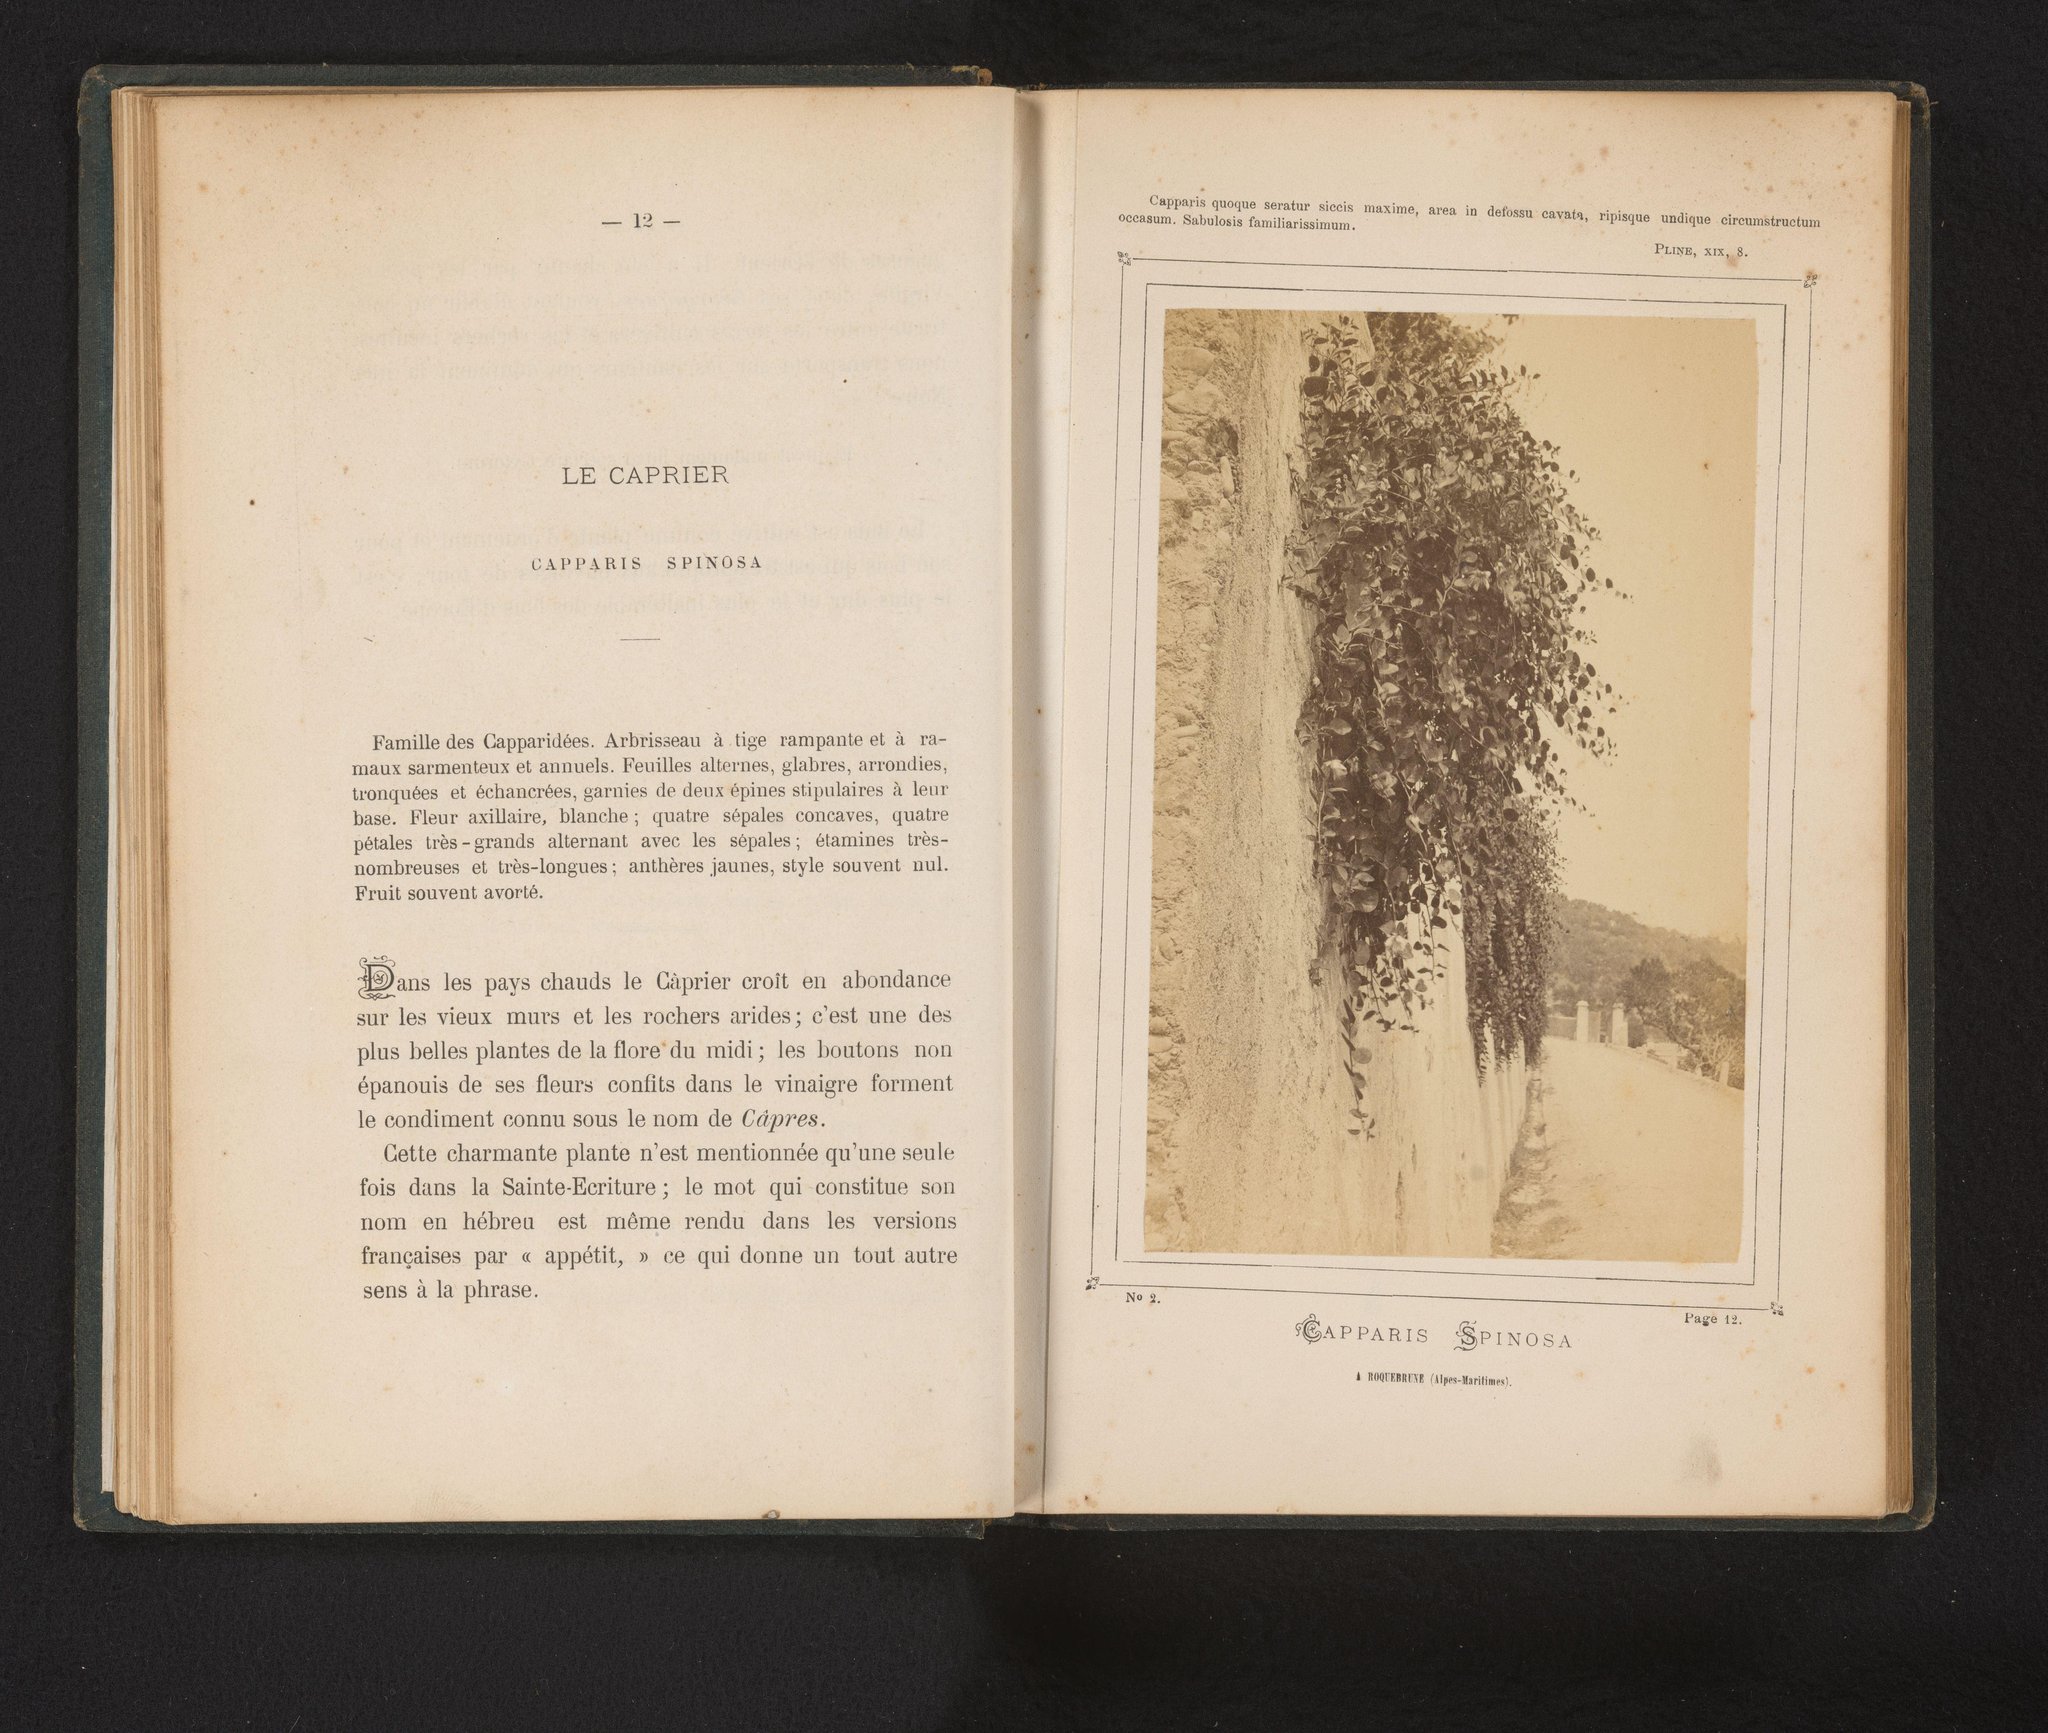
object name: page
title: Capparis Spinosa, A Rocquebrune (Alpes Maritimes)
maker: jean walburg de bray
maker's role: fotograaf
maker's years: 1839-1901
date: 1866-1871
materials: paper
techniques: albumen print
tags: shrubs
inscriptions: inscription: ‘Page 12.’, number: ‘No. 2.’, inscription: ‘Capparis quoque seratur siccis maxime, area in defossu cavata, ripisque undique circumstructum/ occasum. Sabulosis familiarissimum./ PLINE, XIX, 8.’